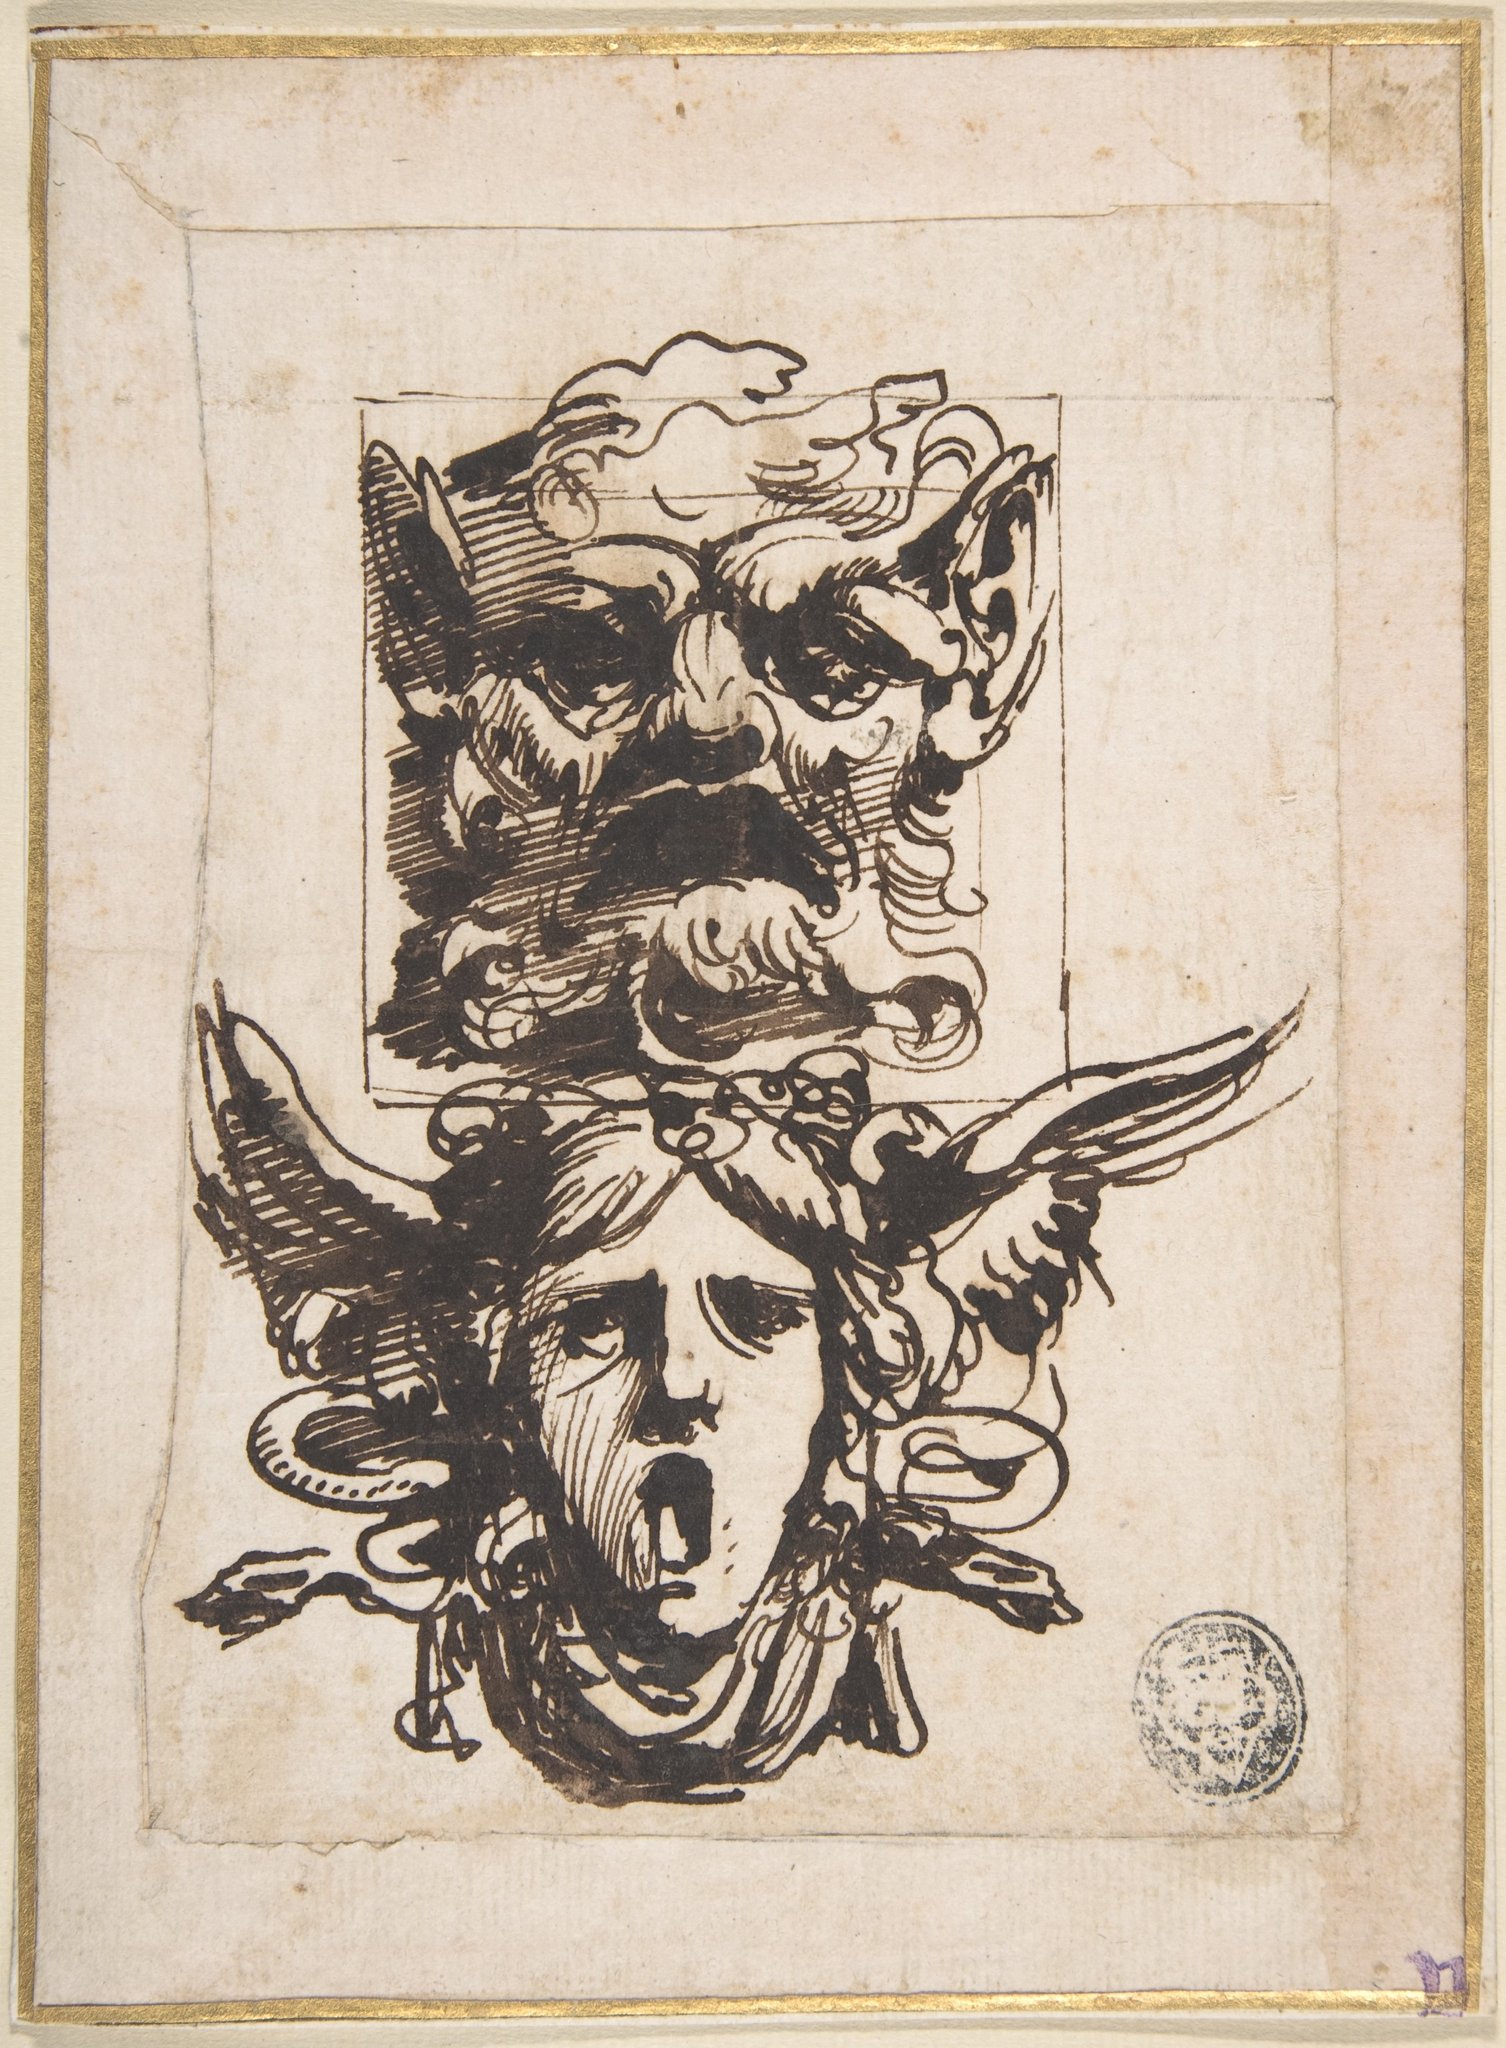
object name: drawing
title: Design for Two Masks Shaped as Satyr and a Winged Medusa Head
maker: carlo bianconi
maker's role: artist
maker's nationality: italian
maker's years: 1732-1802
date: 1752-1802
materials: ink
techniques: pen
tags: medusa,satyrs